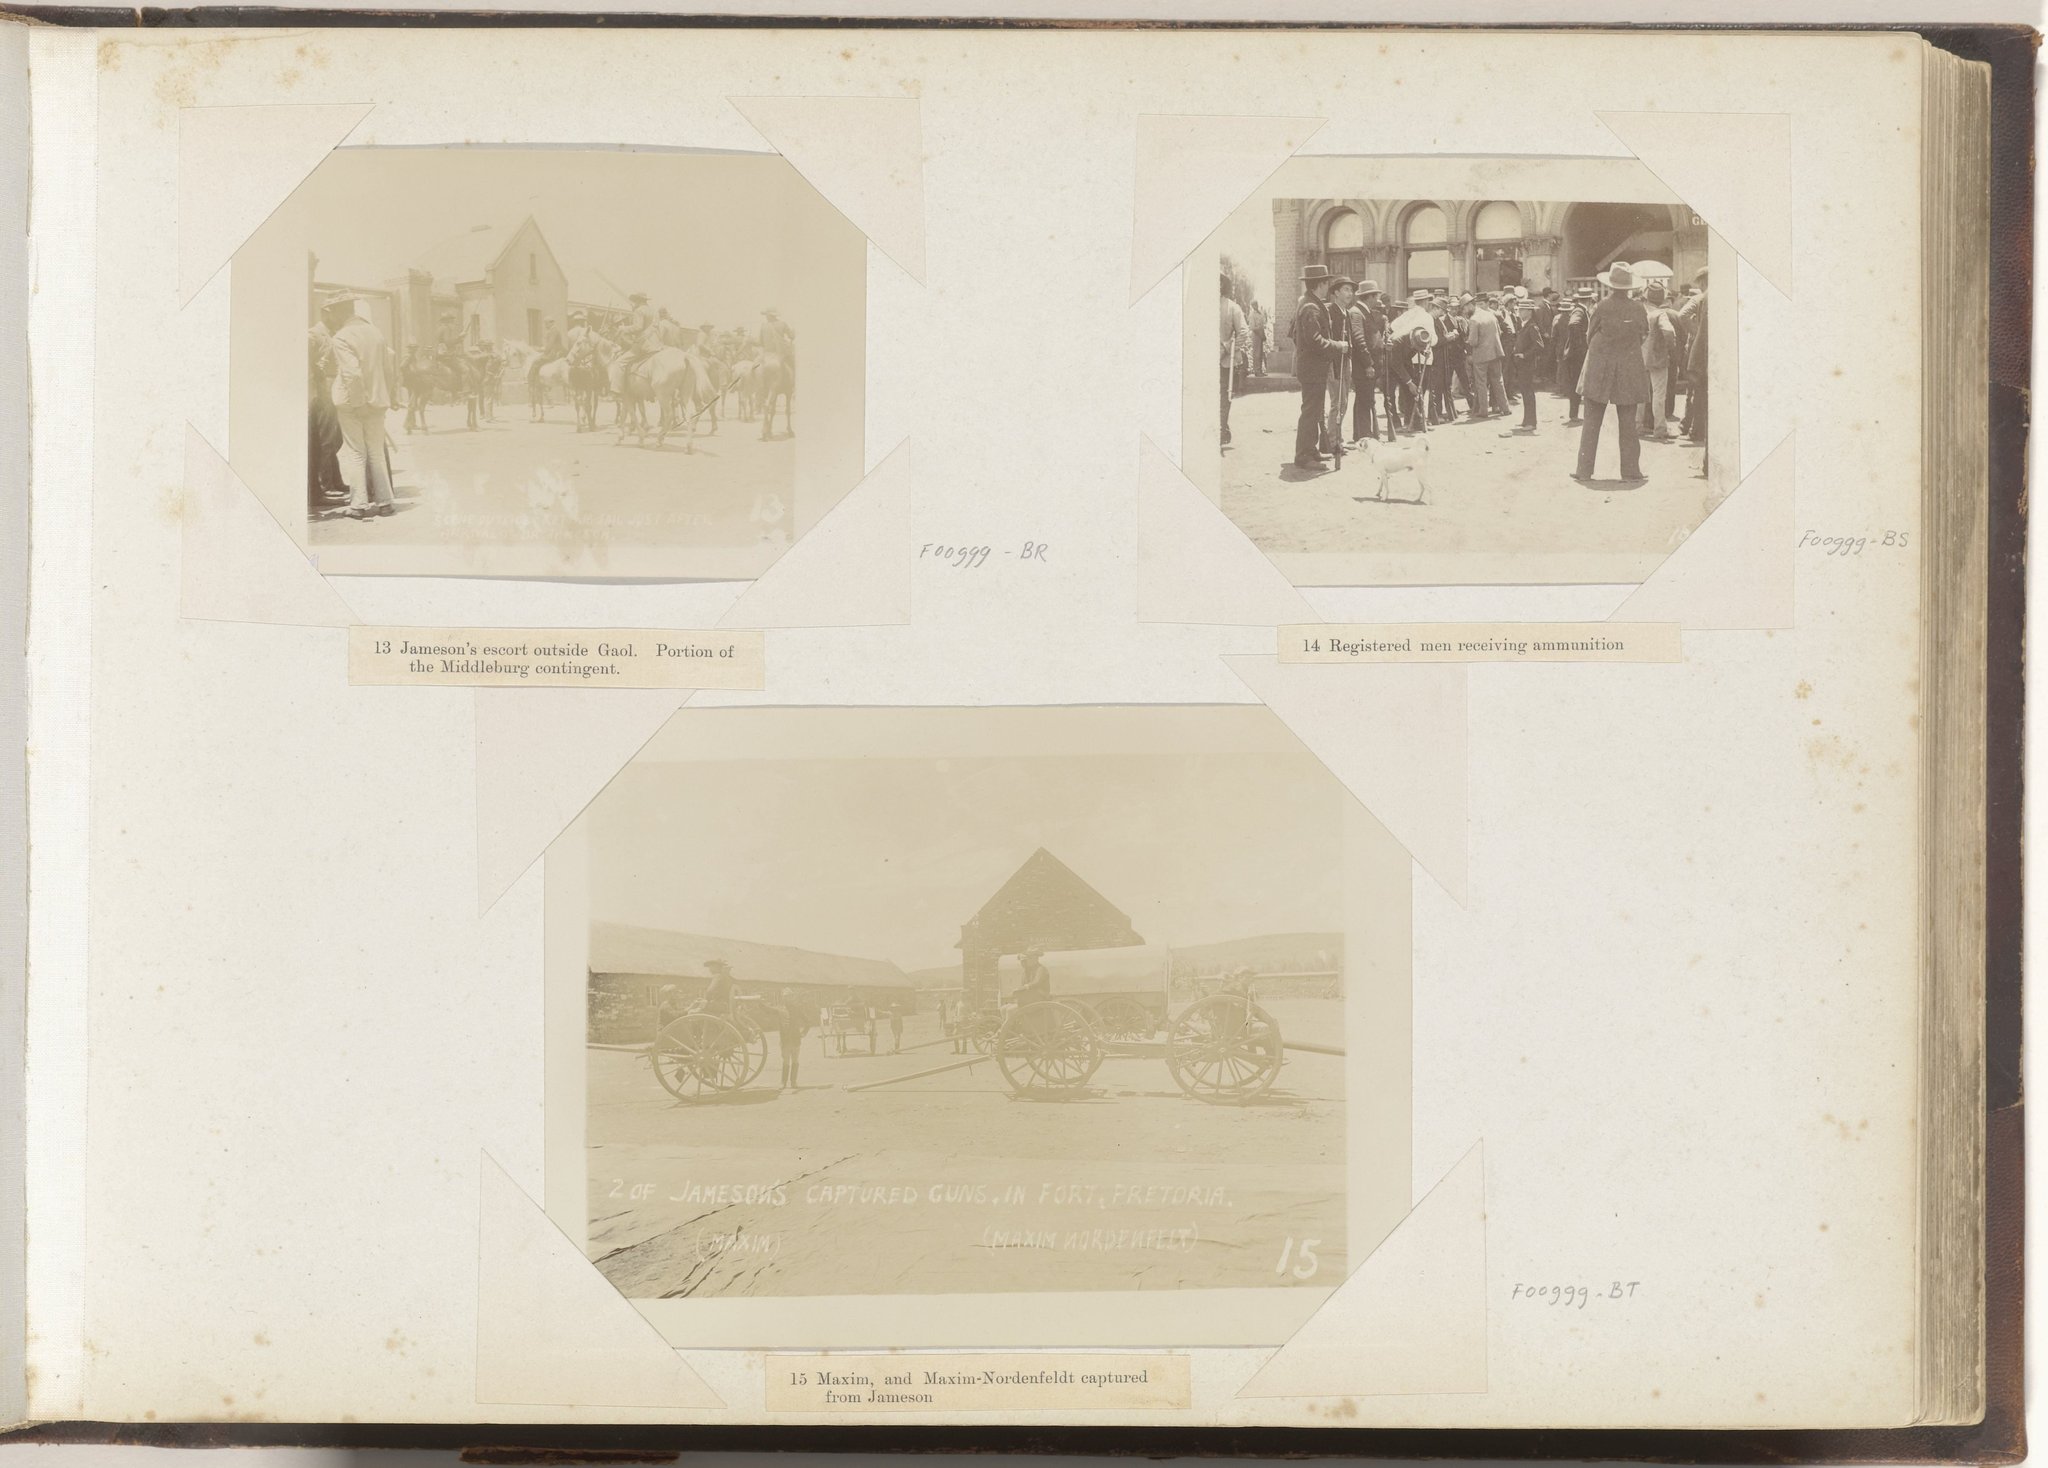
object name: photograph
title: Jameson's escort outside Gaol. Portion of the Middleburg contingent.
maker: Anonymous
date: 1896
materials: paper, photographic support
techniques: gelatin silver print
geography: south africa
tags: land forces (+ cavalry, horsemen)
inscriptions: inscription: ‘Scene outside Pretoria Jail just after arrival of Dr. Jameson.’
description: Onderdeel van Album met 191 foto's van een reis naar en door Zuid-Afrika.